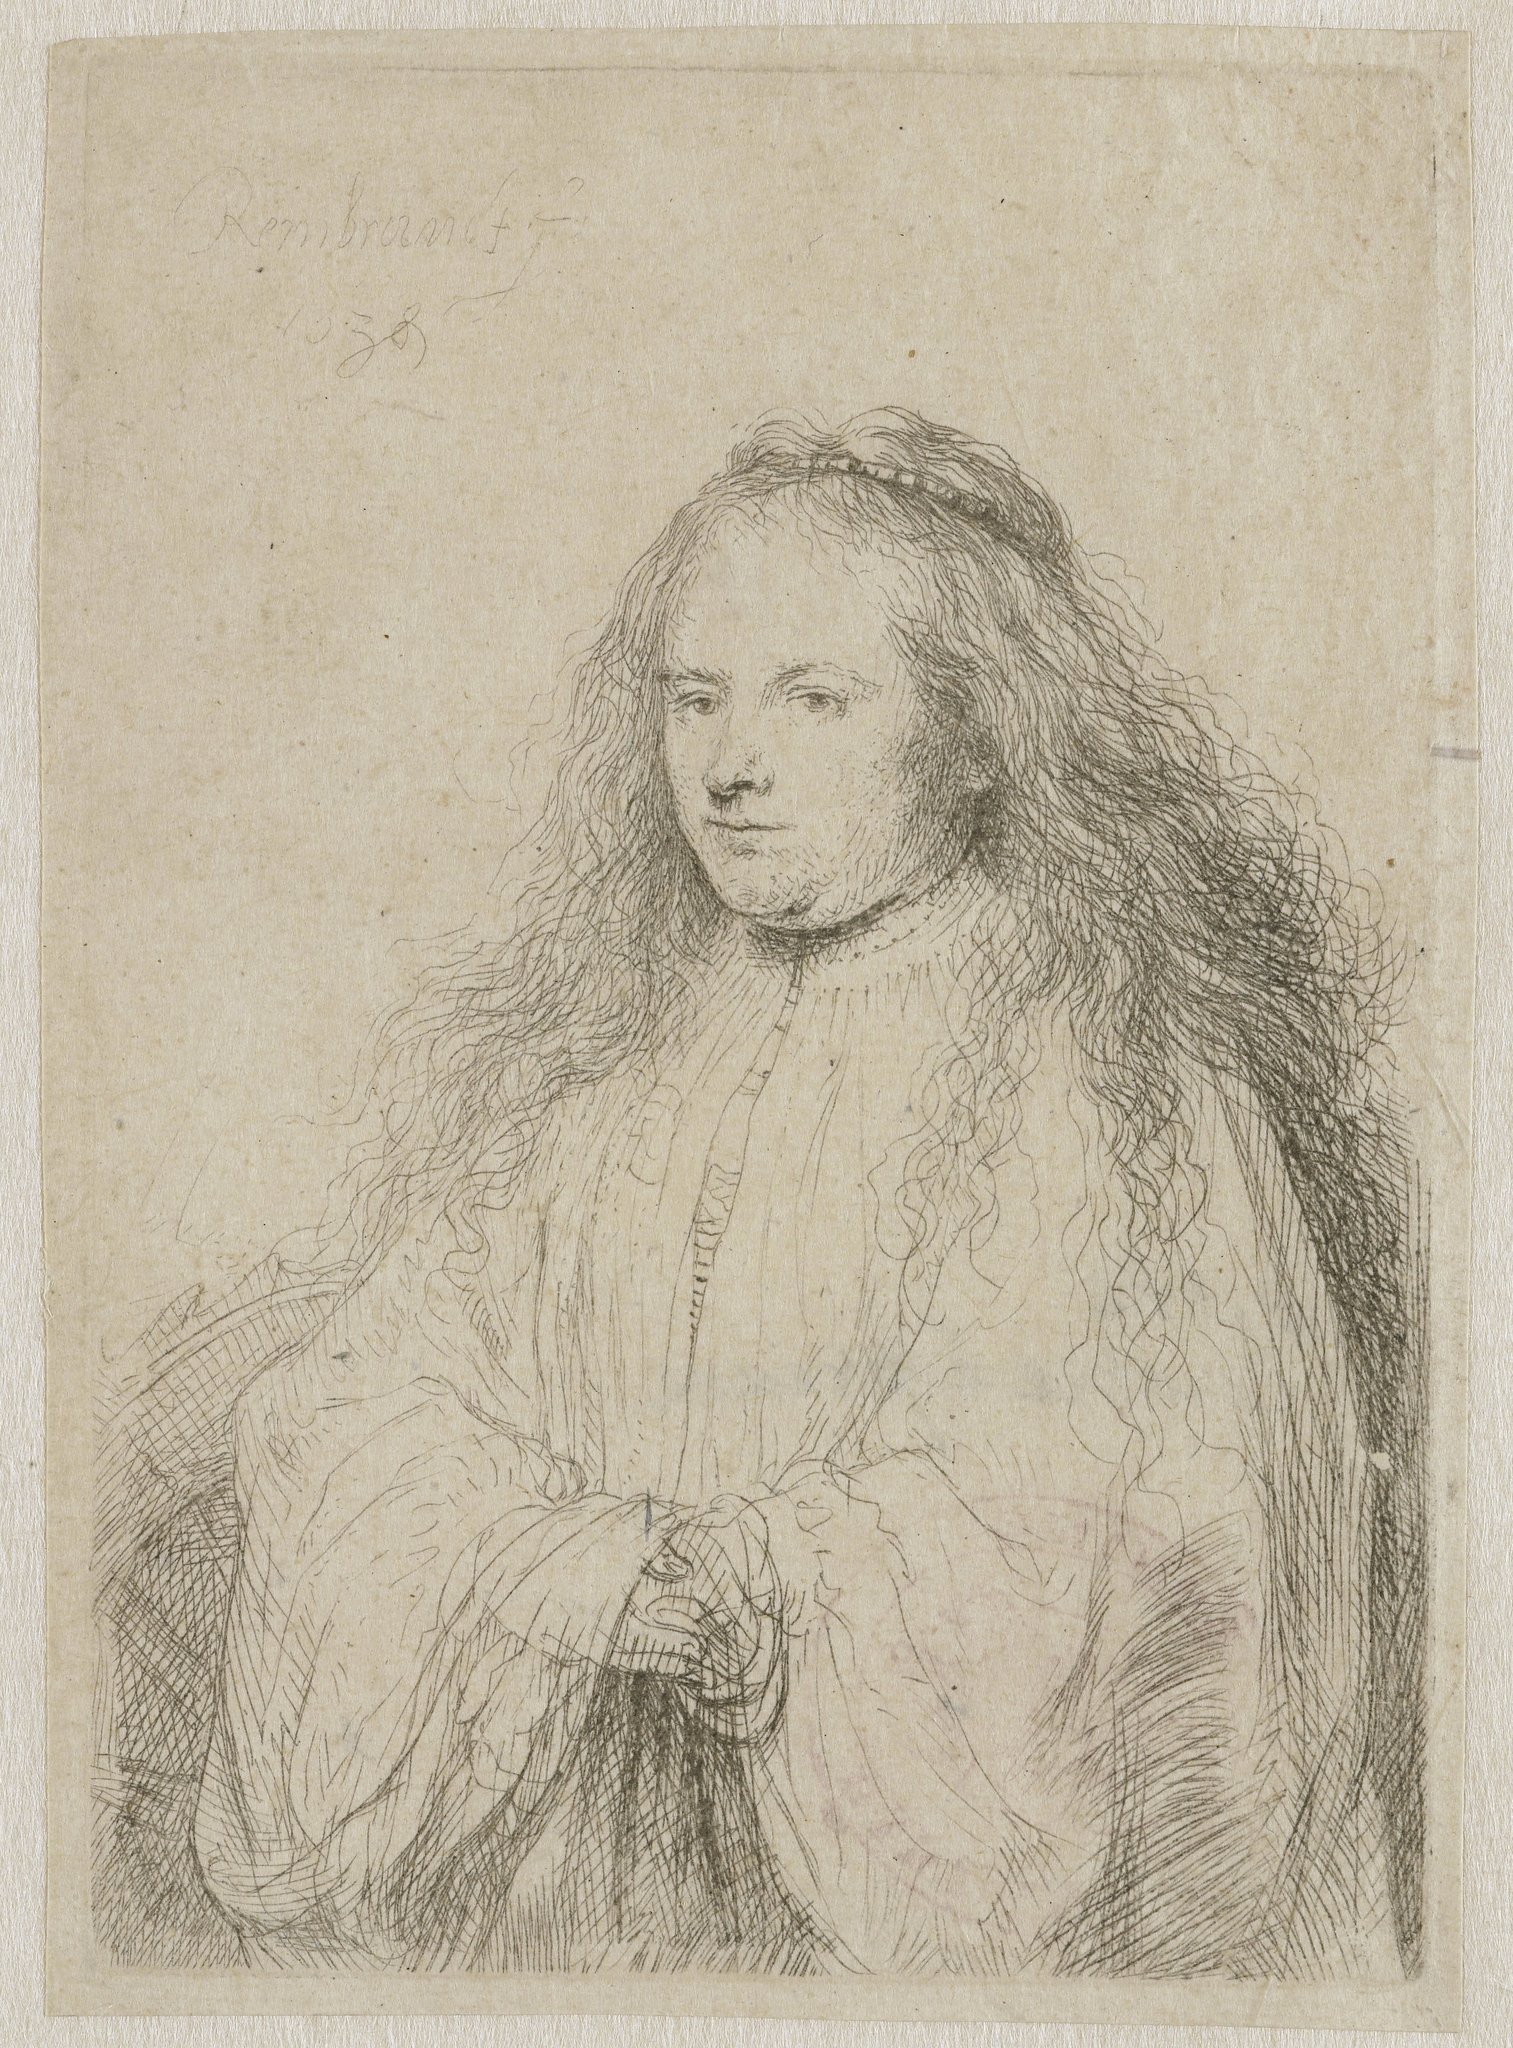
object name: print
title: St Catherine ('the little Jewish bride')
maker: rembrandt van rijn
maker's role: draughtsman, painter, print maker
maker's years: 1606-1669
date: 1638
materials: paper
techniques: printmaking, drypoint, etching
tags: bride (in wedding-dress)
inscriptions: collector's mark: Lugt 240, signature and date: ‘Rembrandt f 1638’